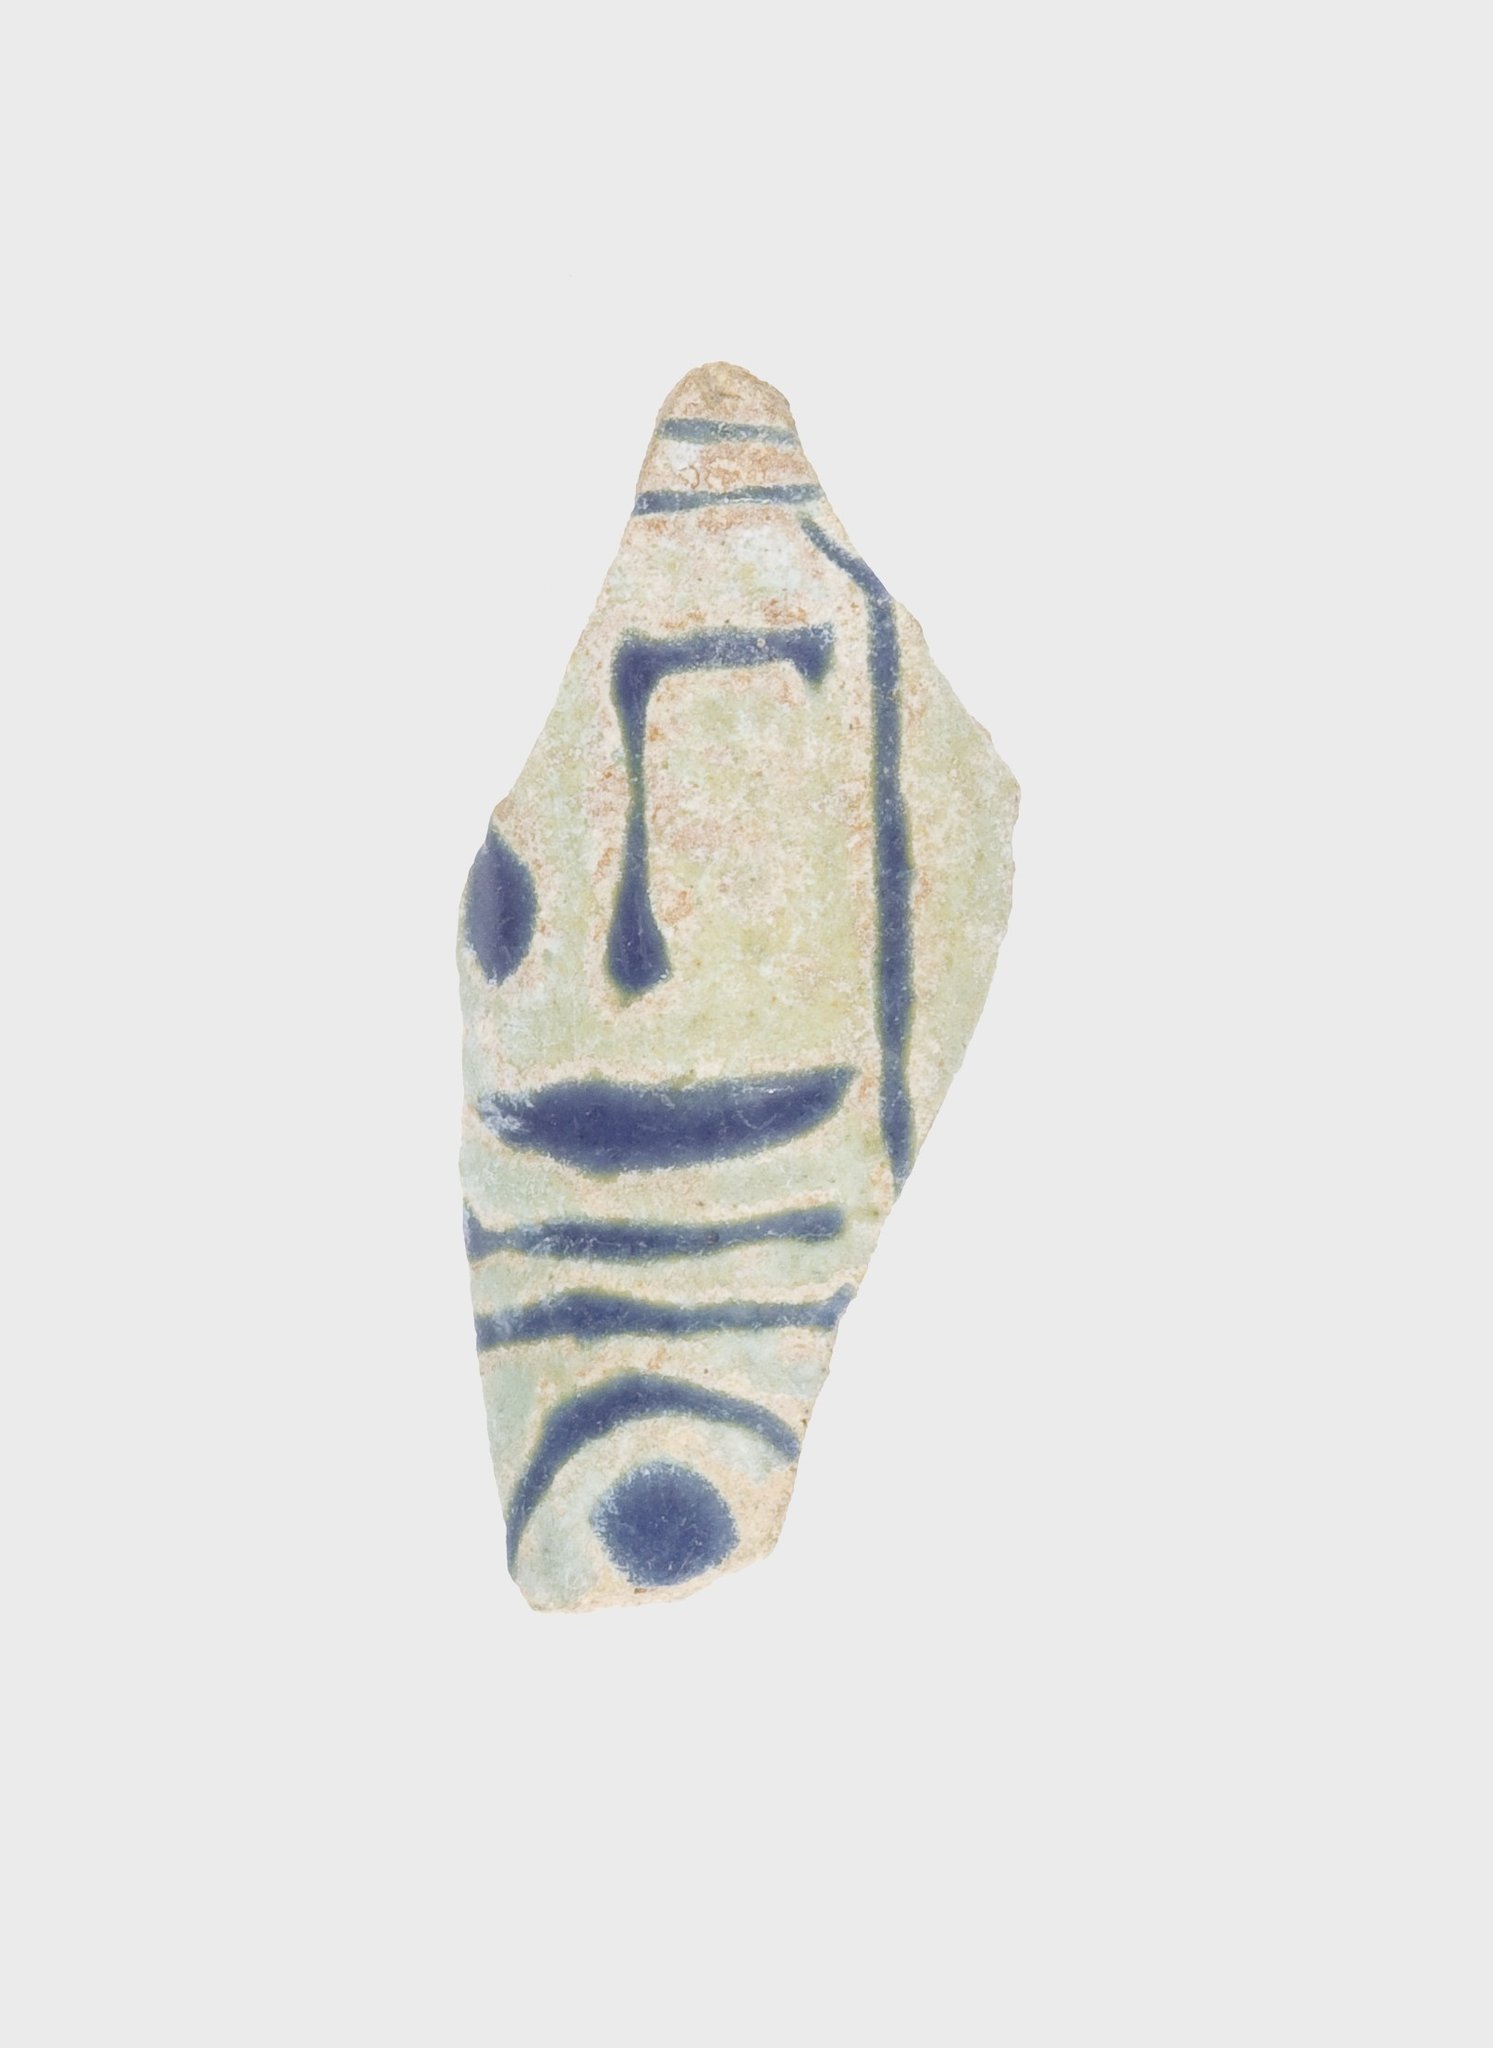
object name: kohl tube fragment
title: Fragment of Kohl Tube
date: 1390-1352 BCE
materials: faience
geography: egypt